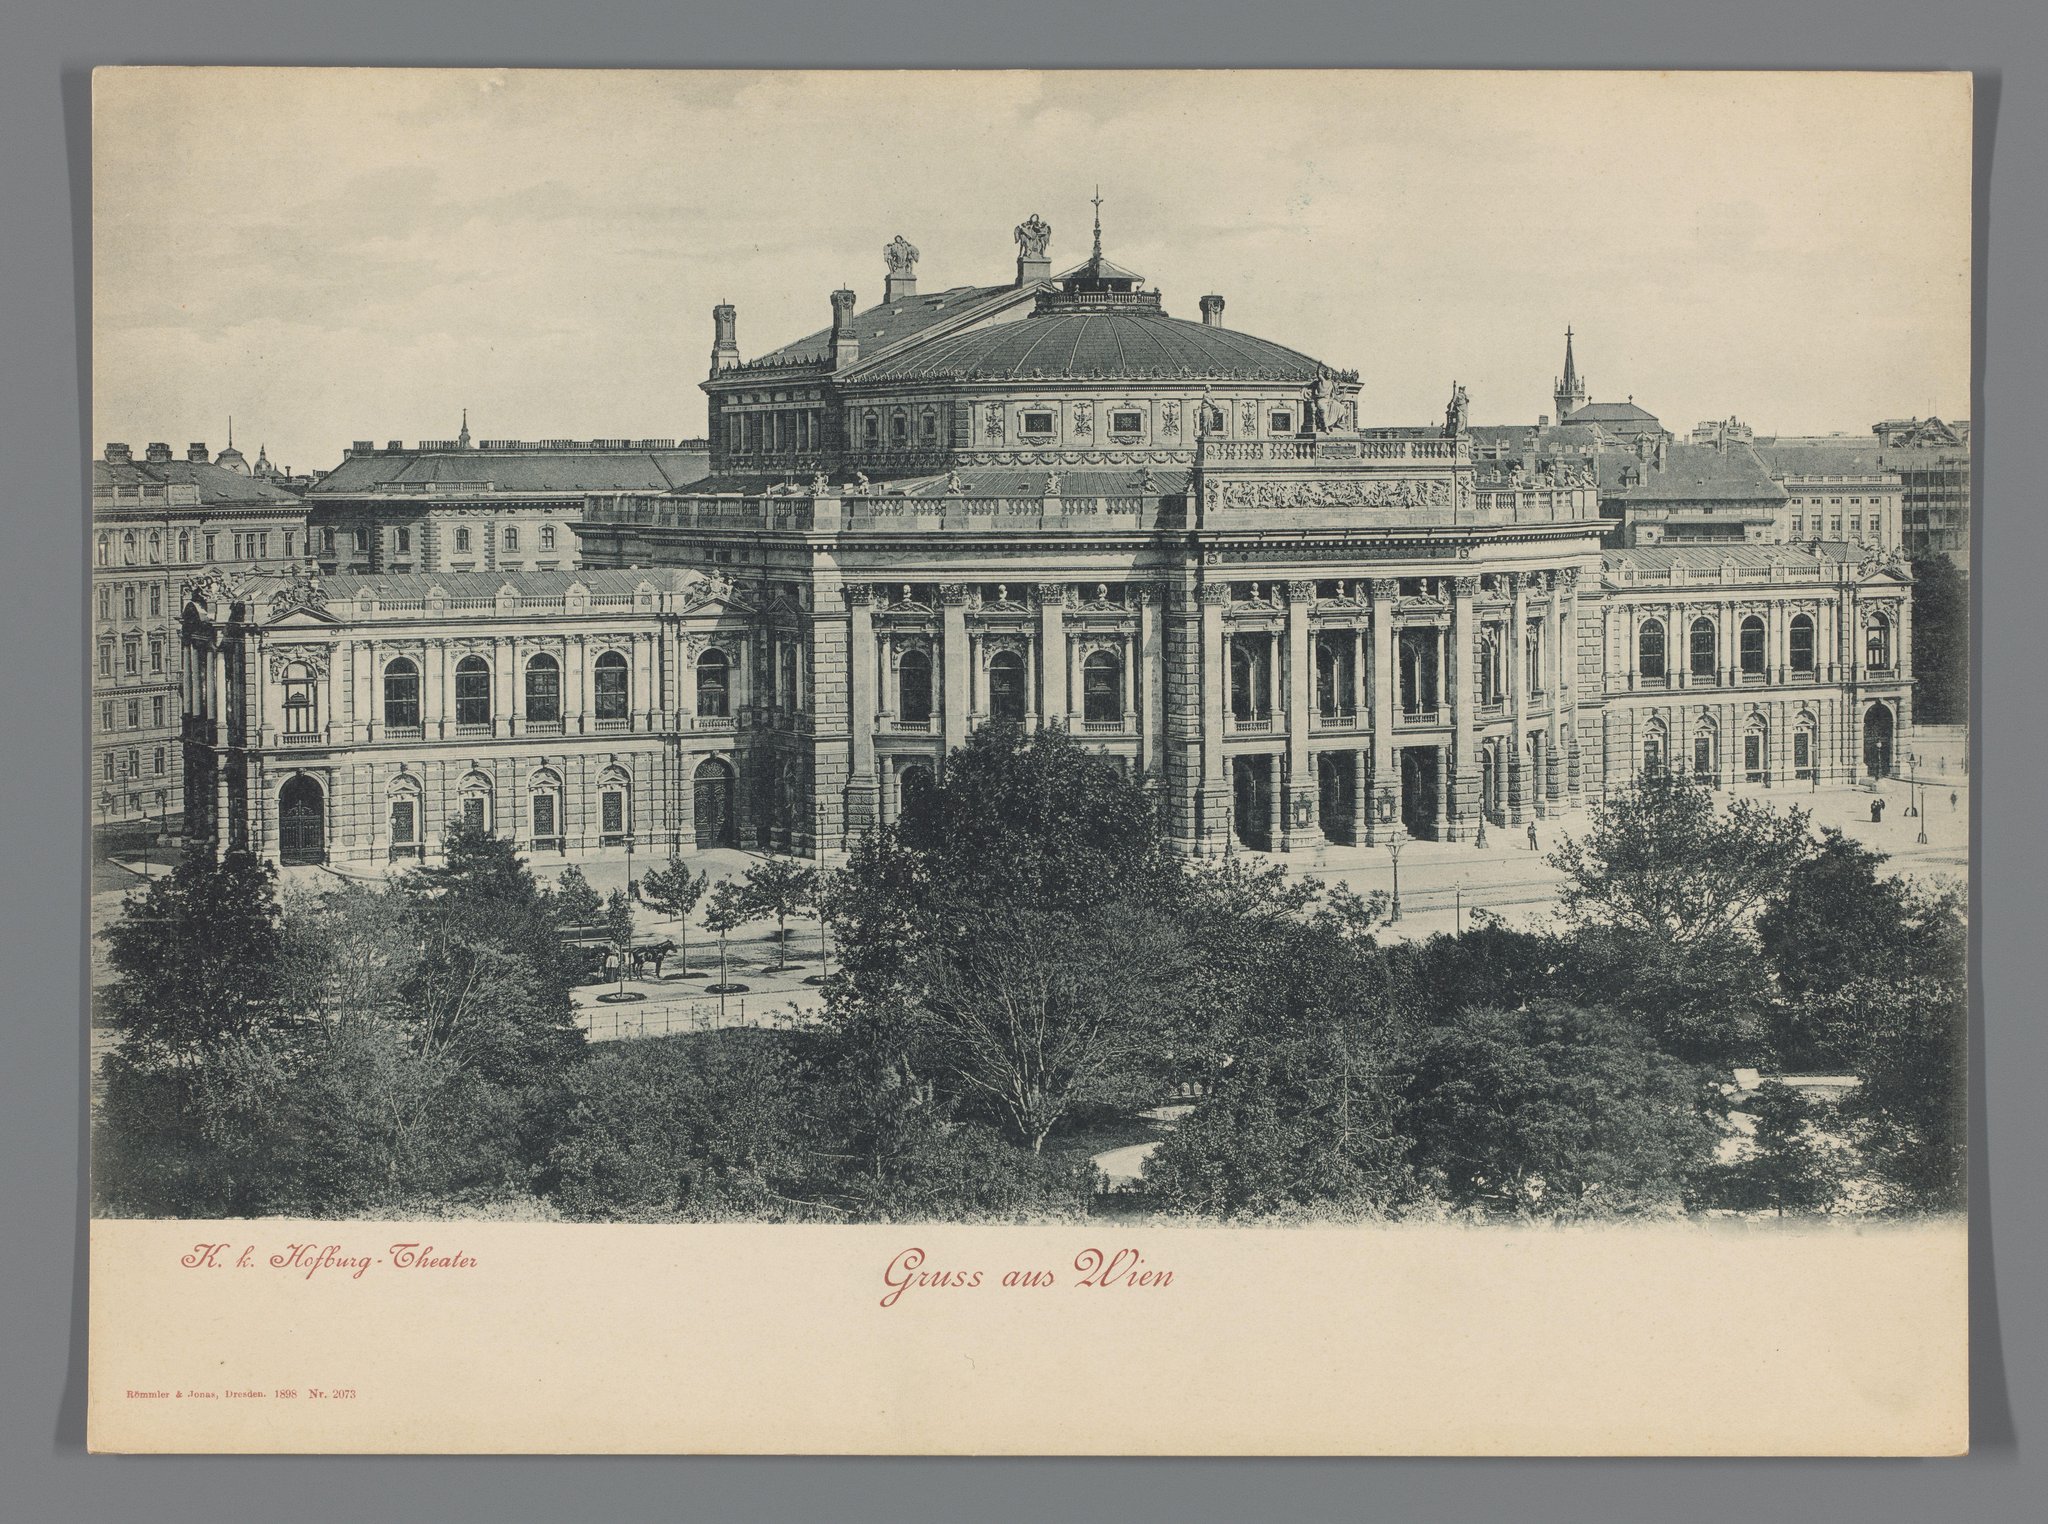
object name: photograph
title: K. k. Hofburg - Theater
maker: Anonymous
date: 1880-1920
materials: photographic support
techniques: photograph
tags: vienna